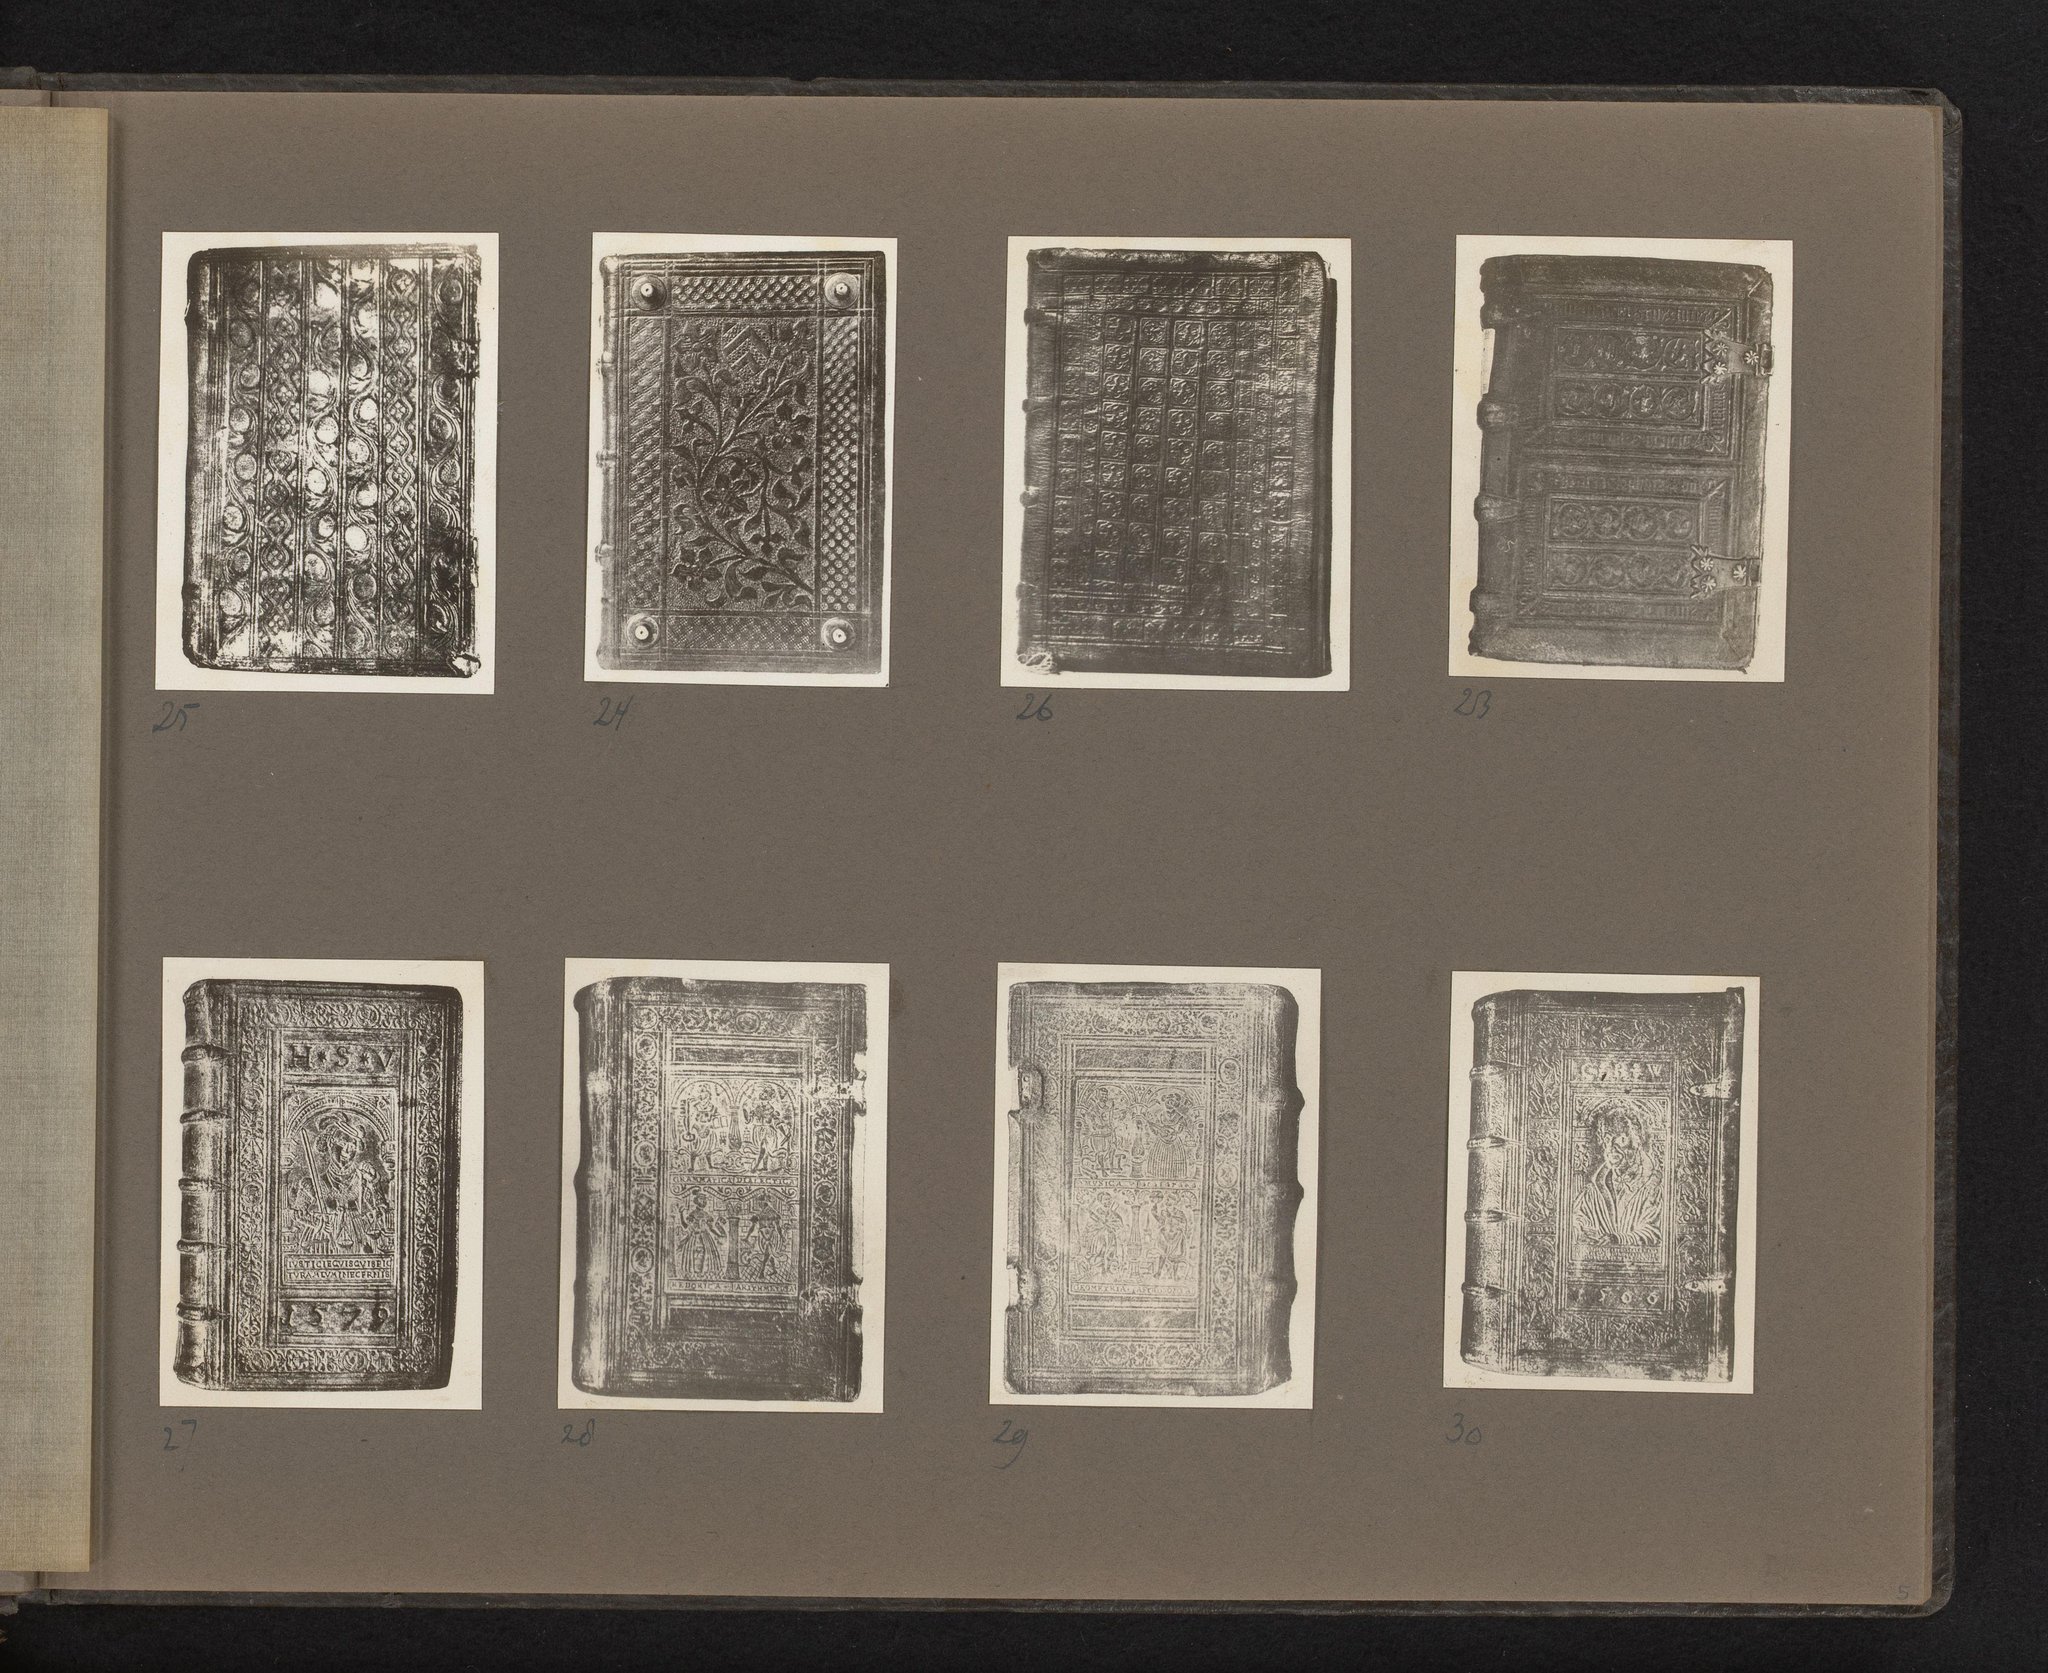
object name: album leaf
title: Acht boekbanden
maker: Anonymous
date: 1920-1940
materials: paper, photographic support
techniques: gelatin silver print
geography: netherlands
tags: book-cover, binding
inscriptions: number: ‘25 - 24 - 26 - 23/ 27 - 28 - 29 - 30’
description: Deze foto's maken deel uit van een album.